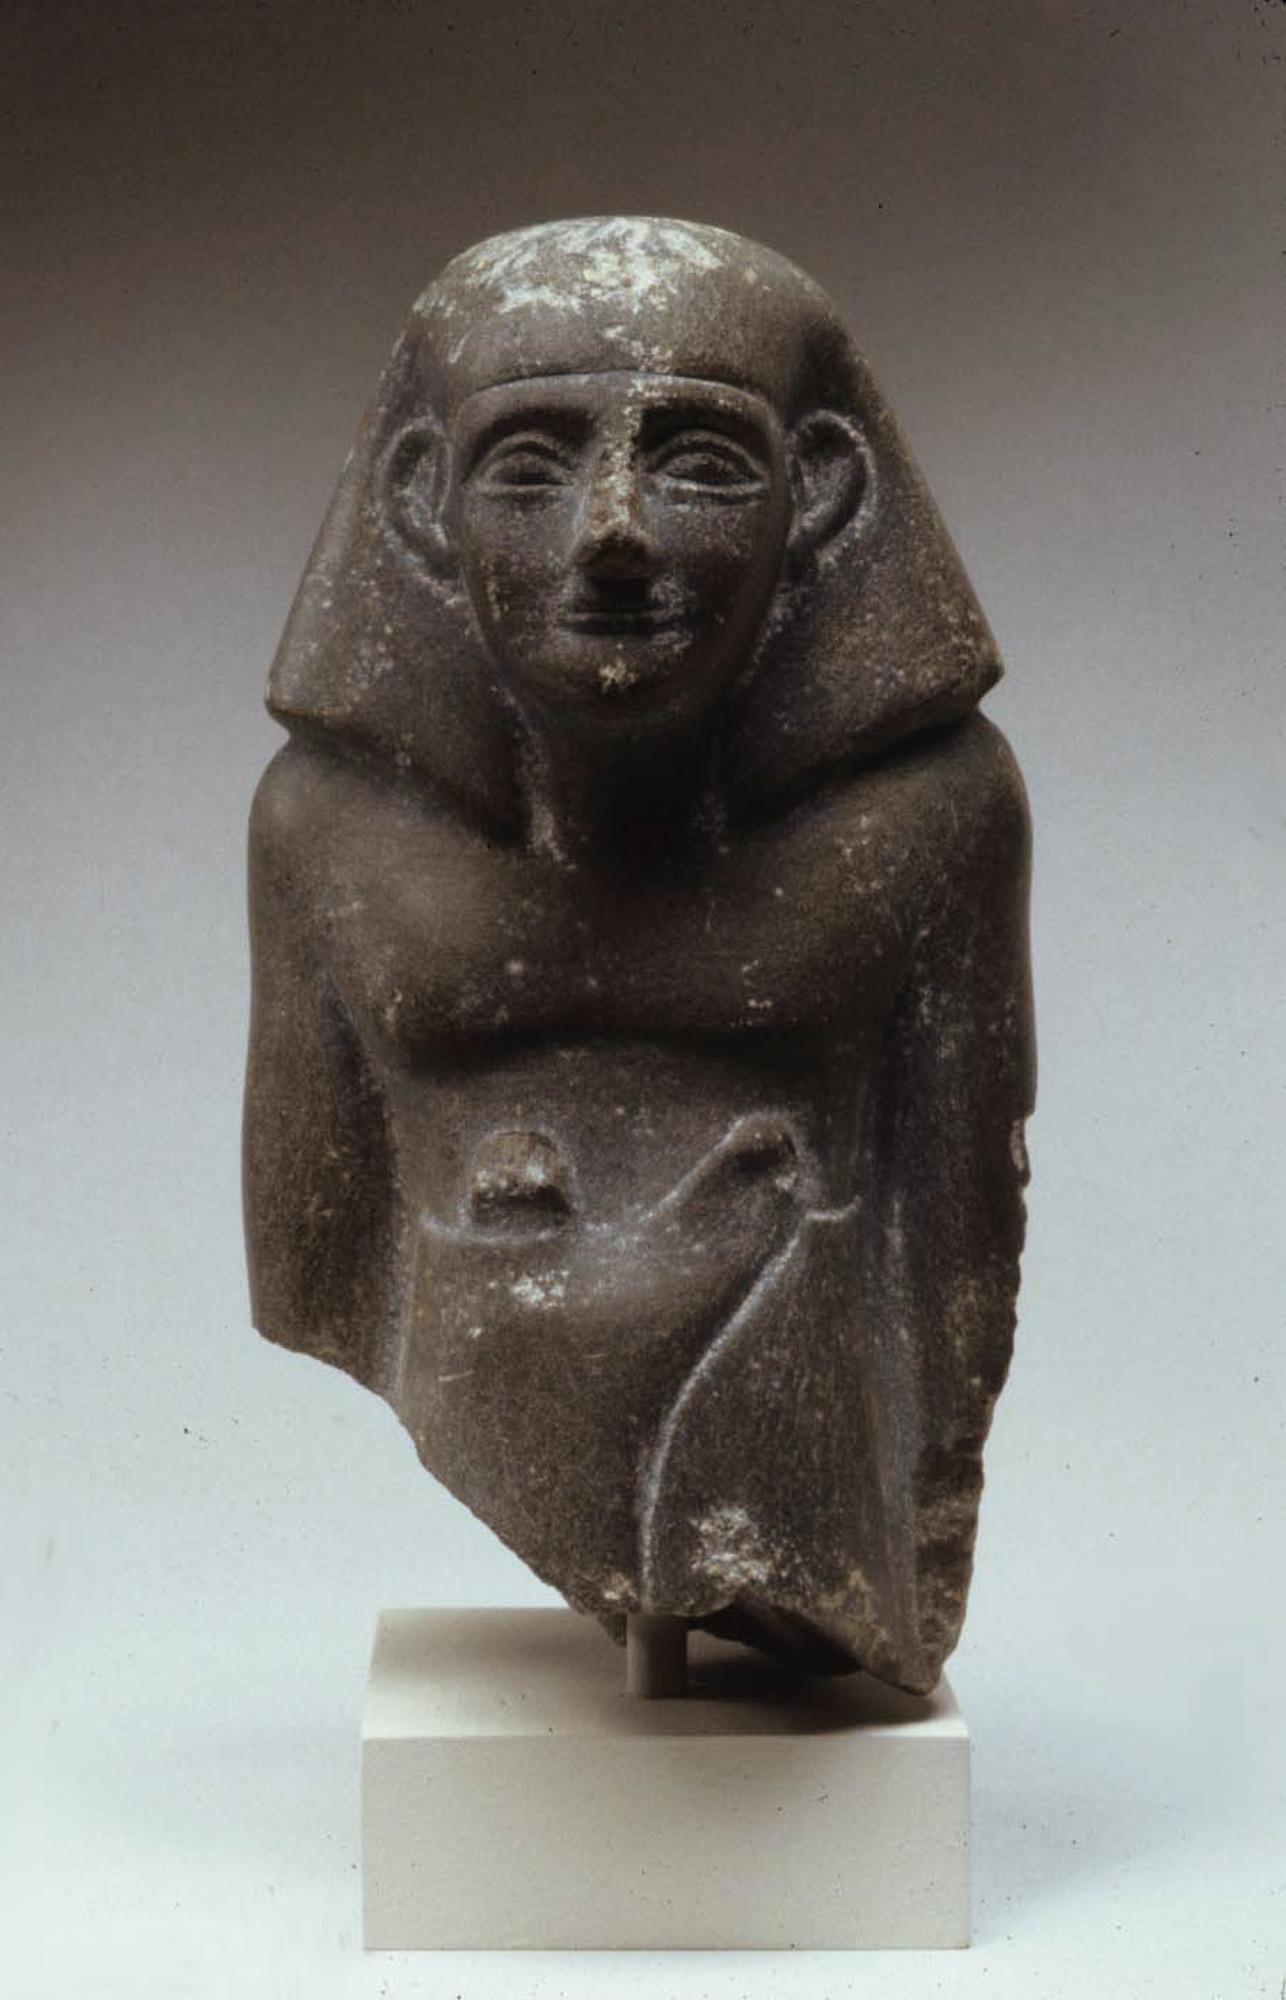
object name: statuette, senbi, upper part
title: Statuette of Senbi in long kilt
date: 1802-1640 BCE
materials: stone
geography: egypt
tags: men